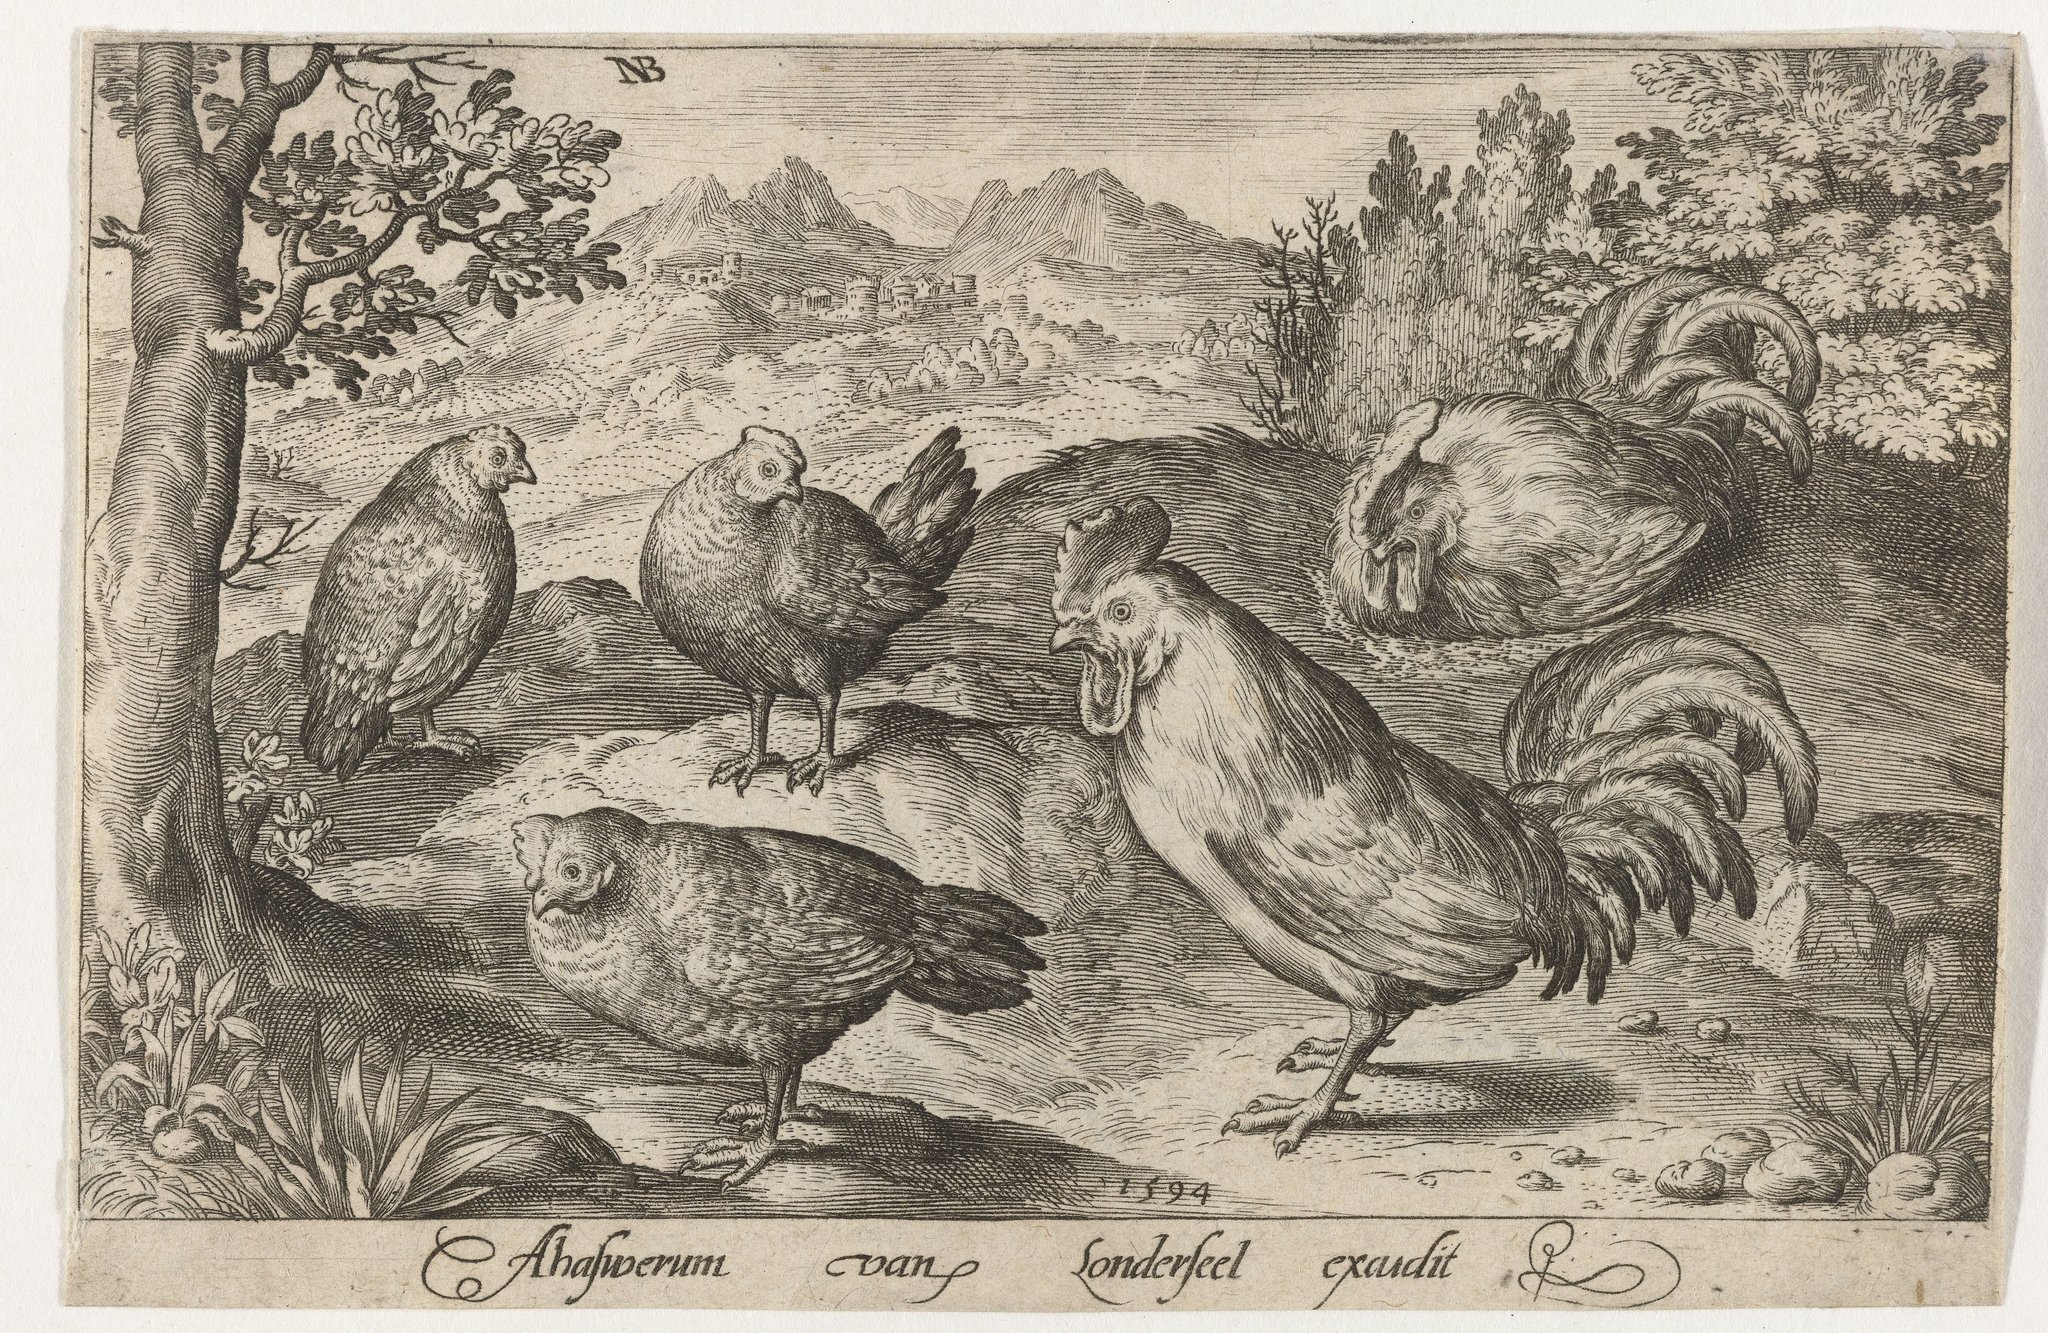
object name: print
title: Drie kippen en twee hanen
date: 1594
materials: paper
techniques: engraving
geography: antwerp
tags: fowl (cock, hen, chicken, etc.)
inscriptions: collector's mark: Lugt 2228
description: Prent uit serie van twaalf prenten met vogels en insecten. Bij Hollstein zijn bladen van een andere serie prenten afgebeeld, zie De Groot 1988, p. 37.